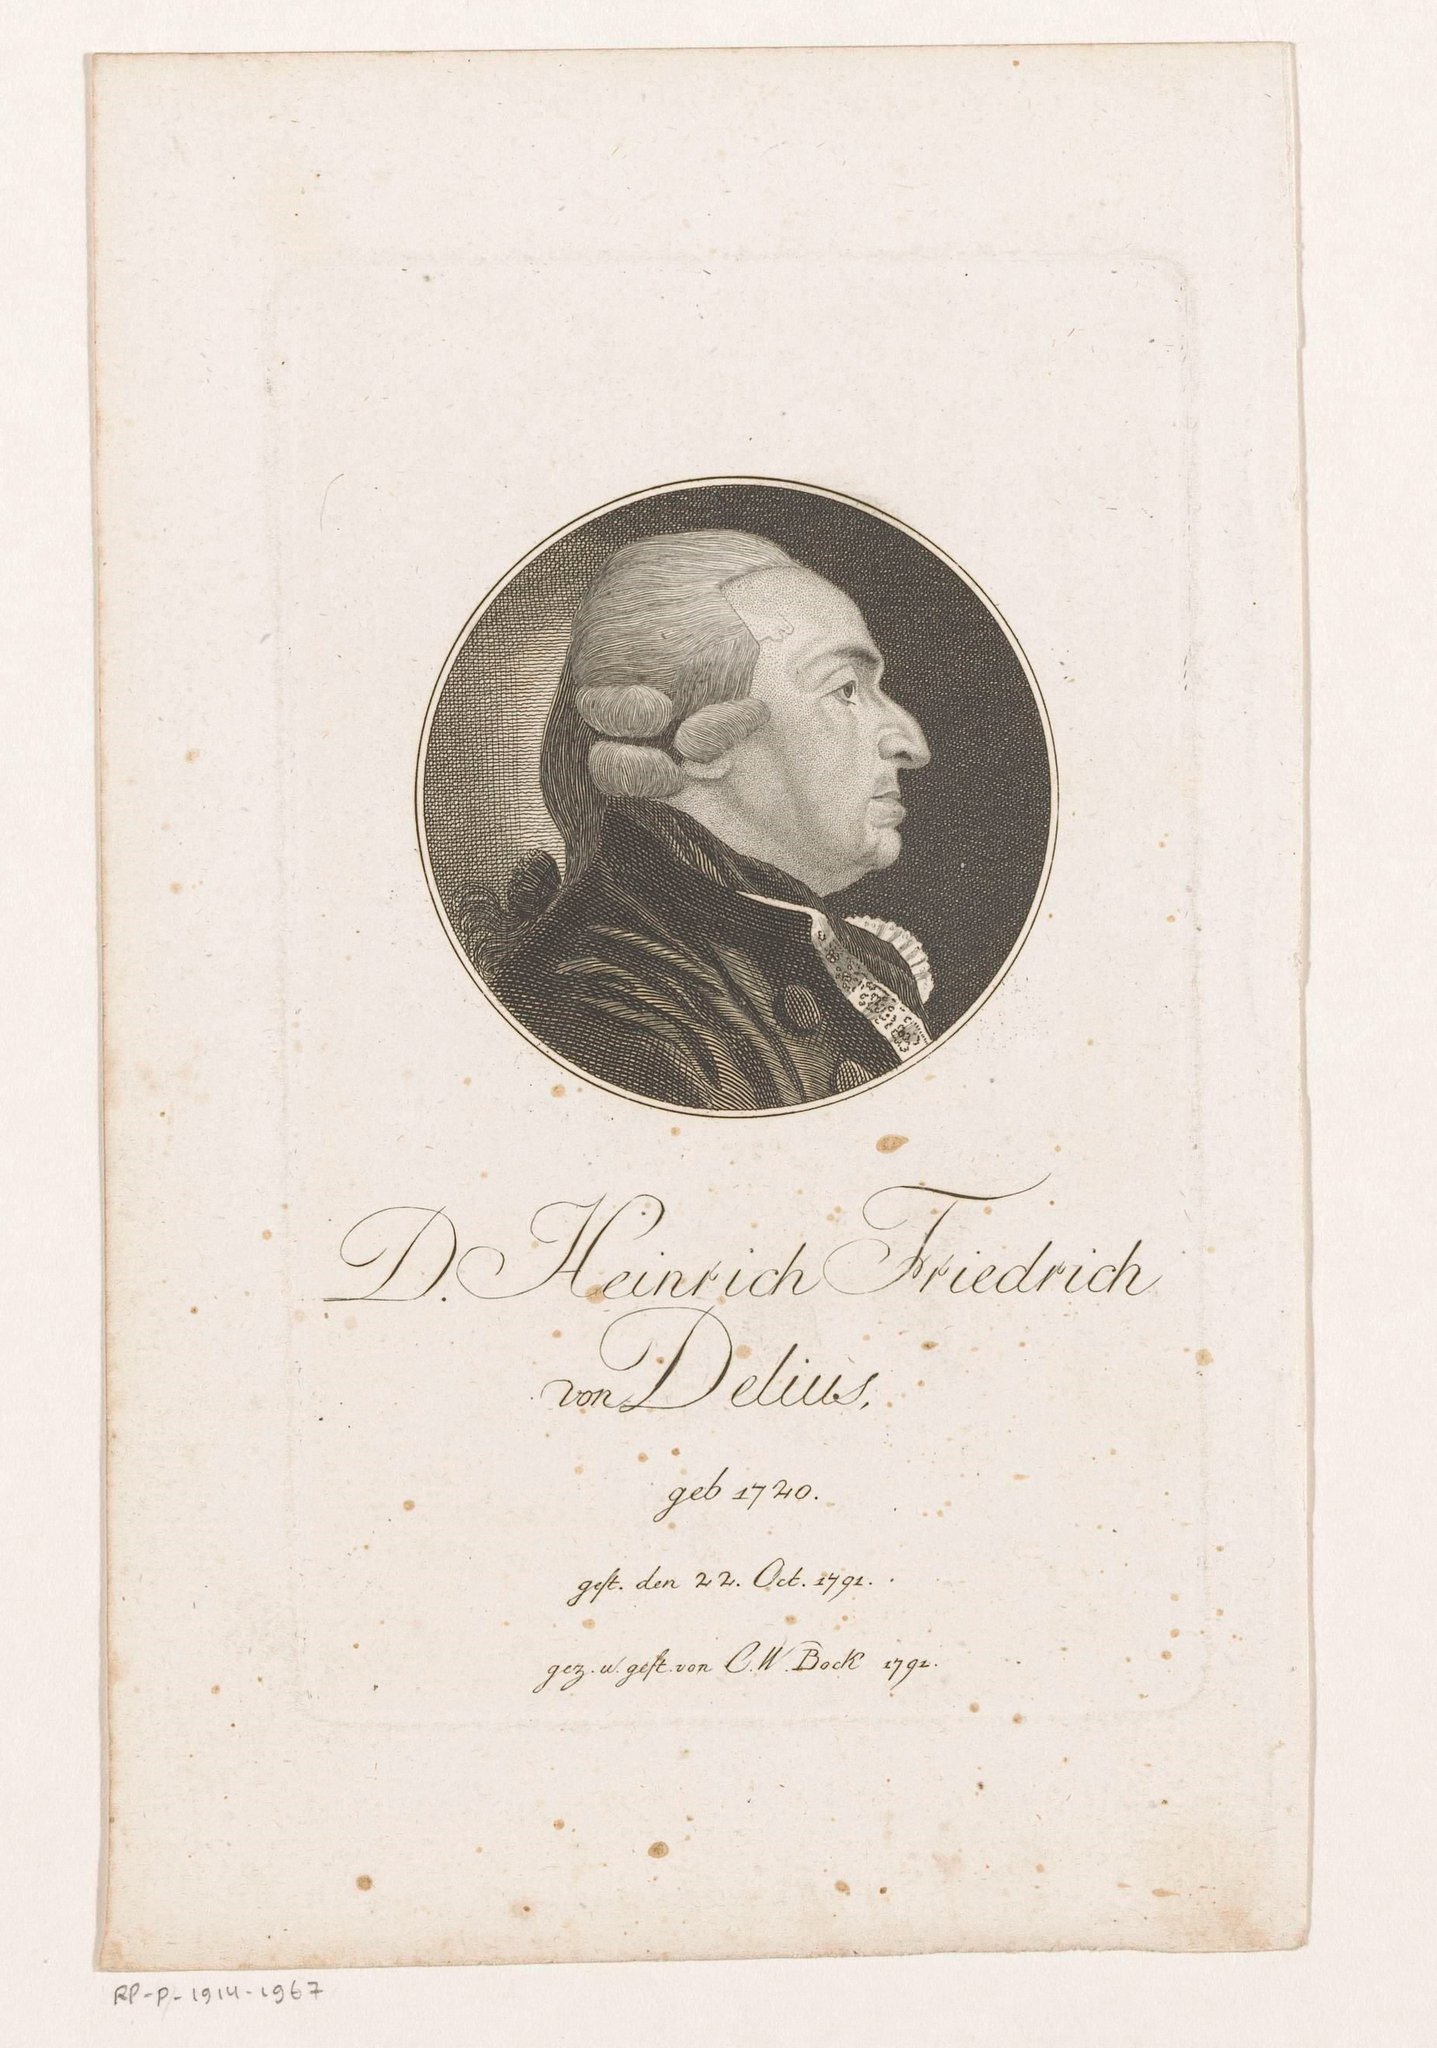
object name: print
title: Portret van Heinrich Friedrich von Delius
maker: christoph wilhelm bock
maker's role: print maker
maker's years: 1755-1836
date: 1791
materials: paper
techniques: engraving, etching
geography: nuremberg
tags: historical persons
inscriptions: collector's mark: Lugt 2228